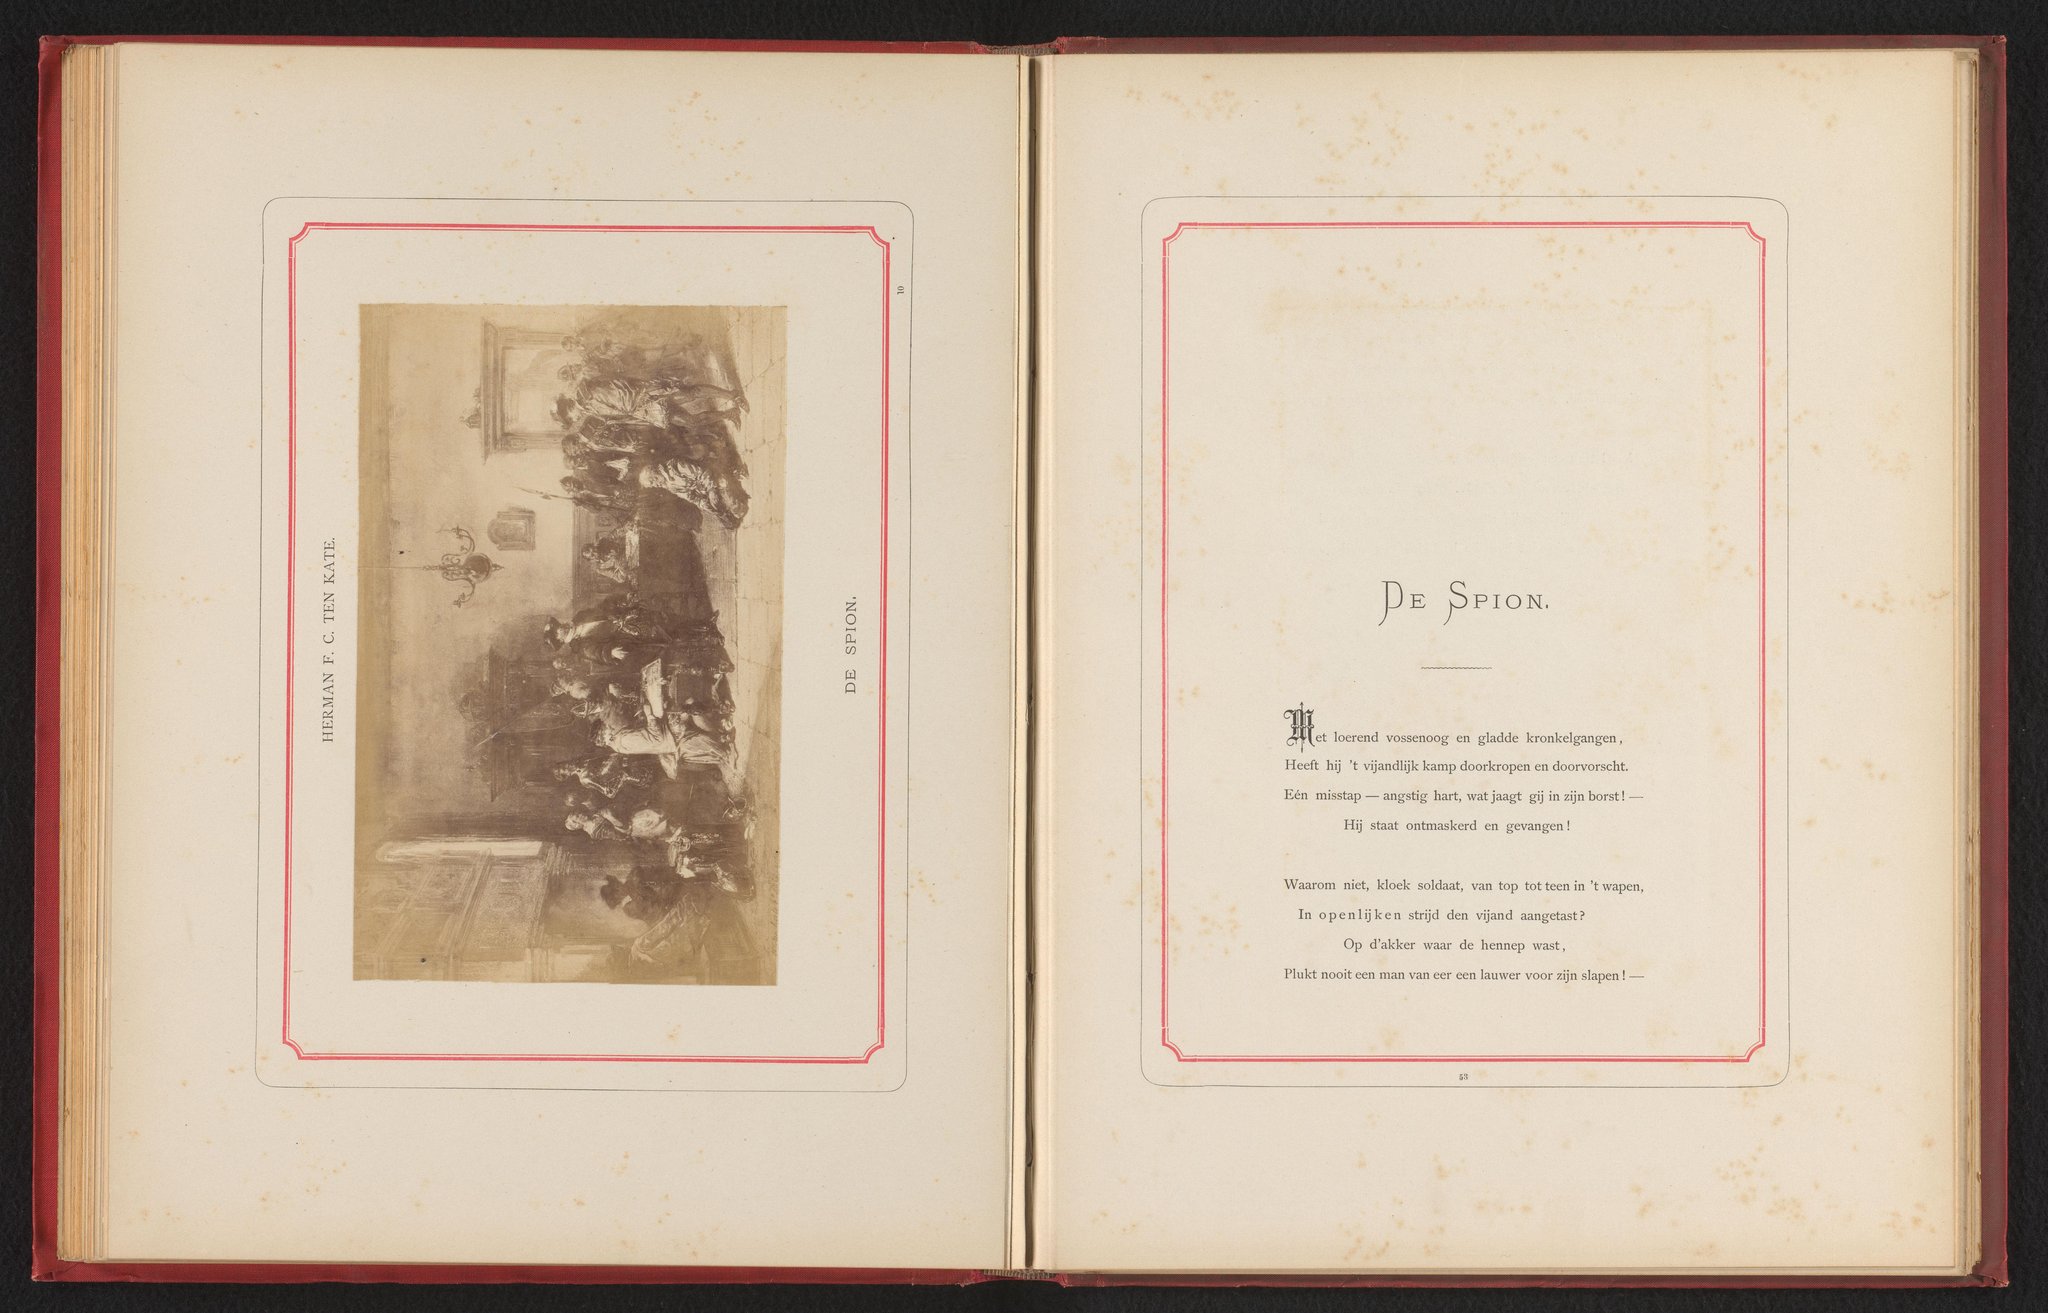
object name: page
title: De spion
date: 1865-1878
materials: paper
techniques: albumen print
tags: administration of justice, trial